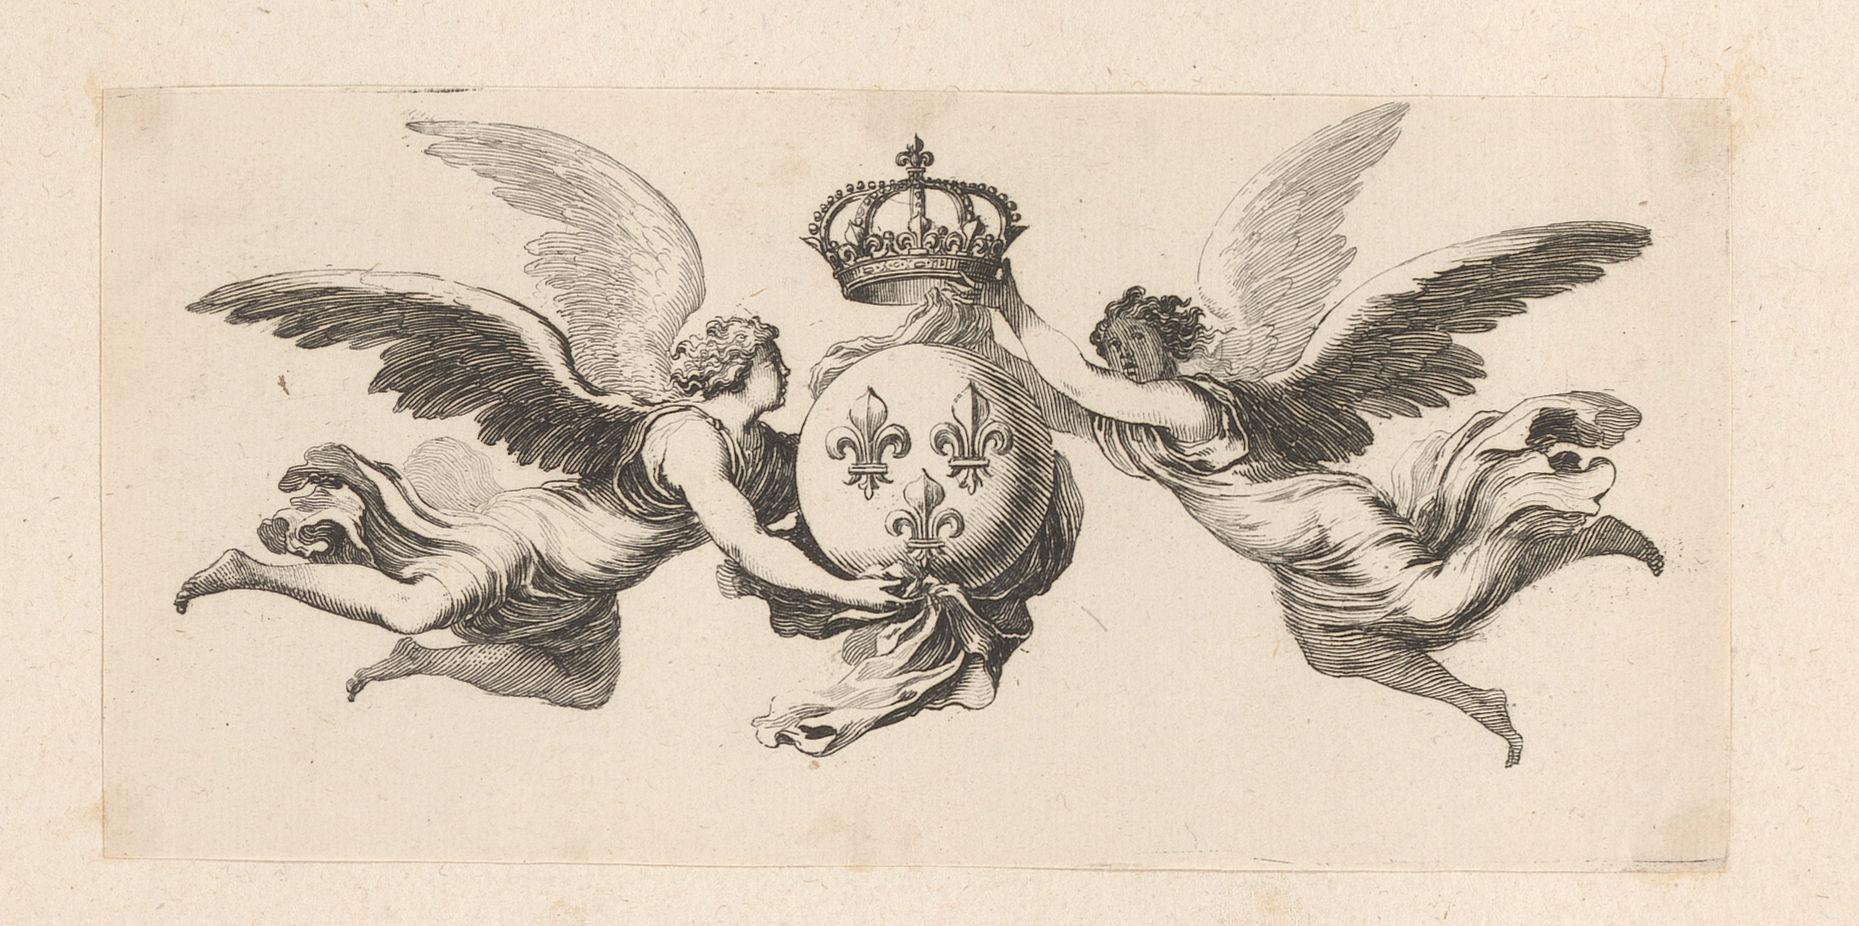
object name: album leaf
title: Twee vliegende engelen met de koninklijke kroon en een globe met de fleur de lis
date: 1668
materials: paper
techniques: etching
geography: paris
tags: crown (symbol of sovereignty), angels, armorial bearing, heraldry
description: Prent uit: Félibien, André. Devises pour les tapisseries du Roy, où sont représentez les quatre élémens (...). Parijs: Claude Blageart, 1668.